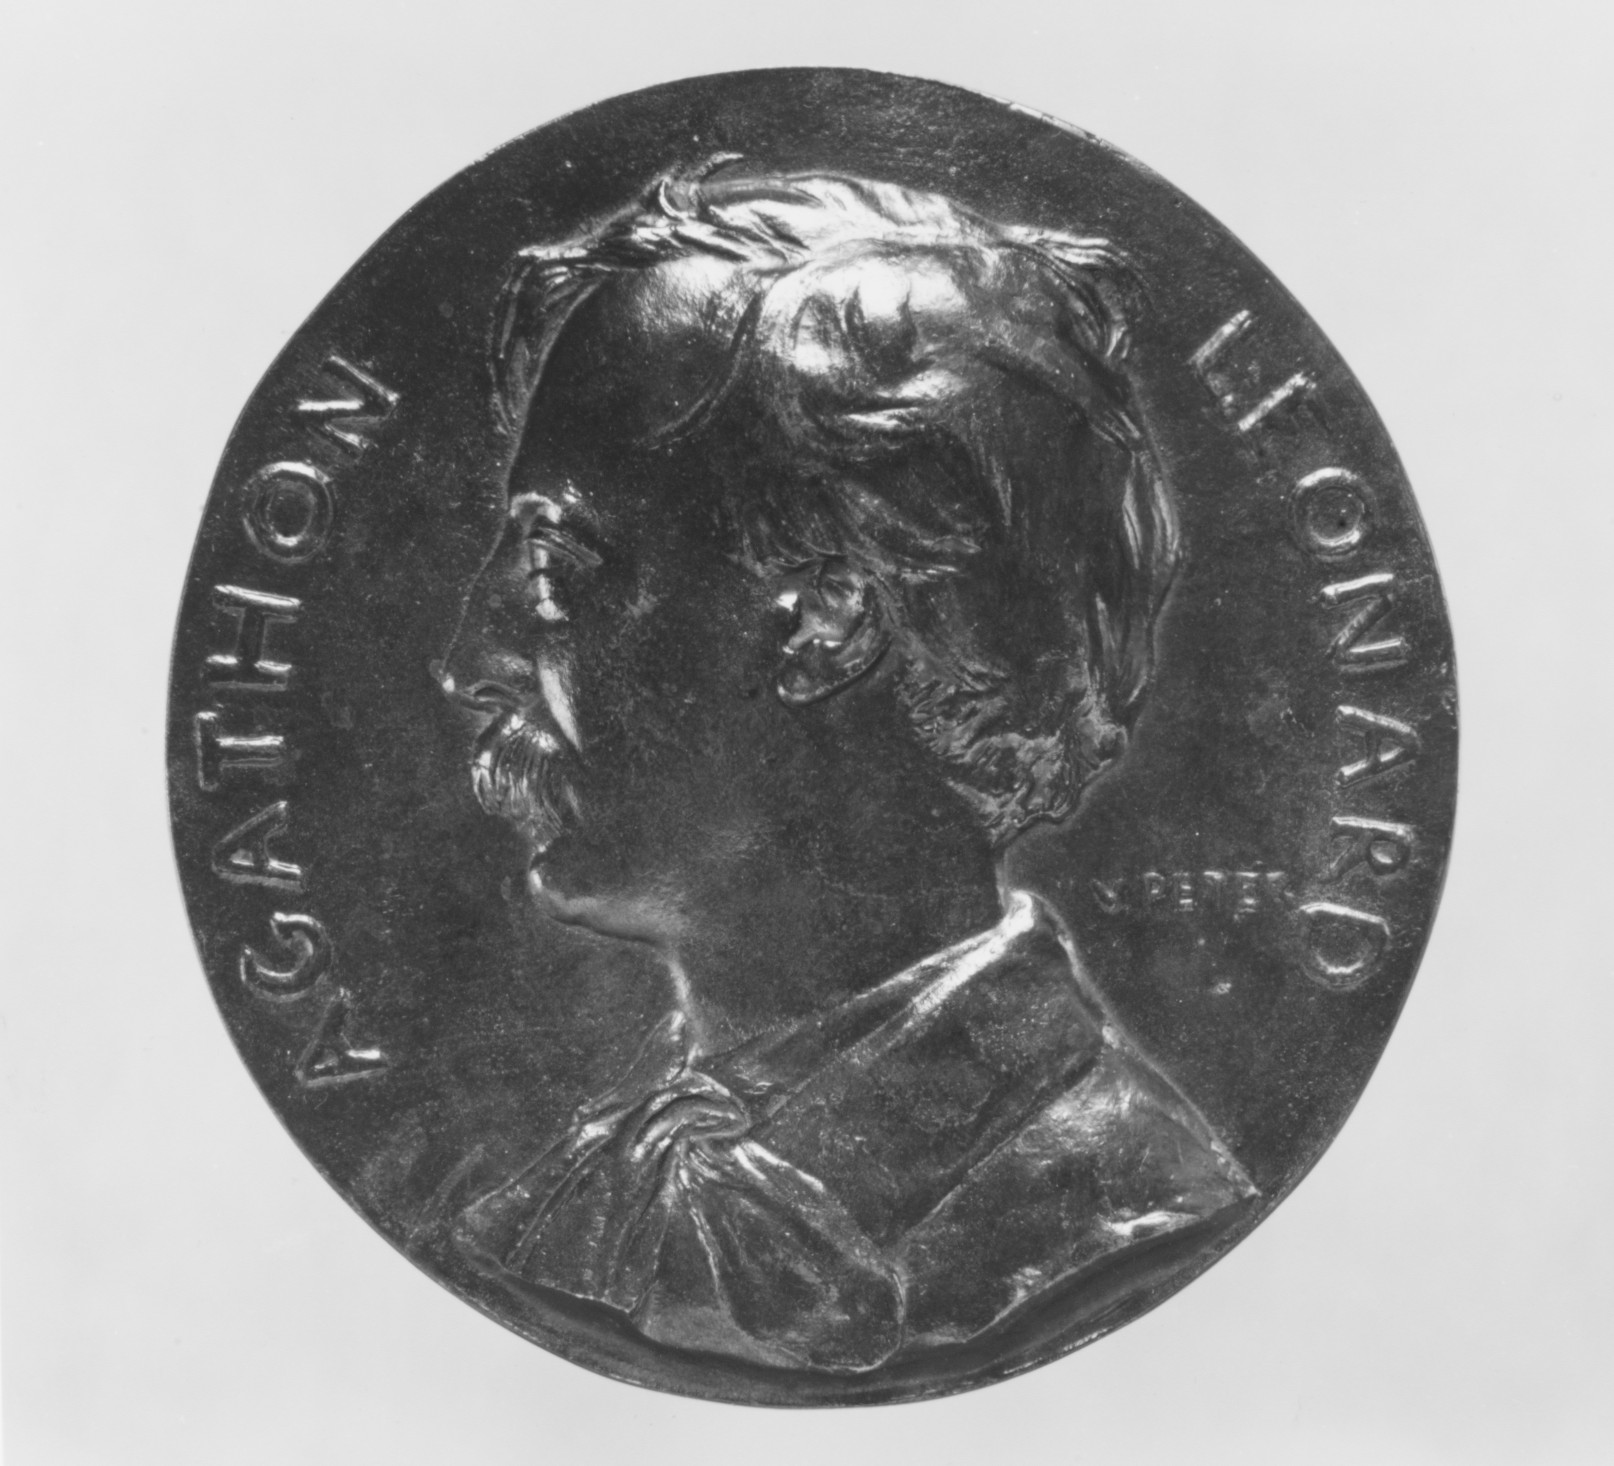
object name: medallion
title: Agathon Léonard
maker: victor peter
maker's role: artist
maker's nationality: french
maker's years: 1840-1918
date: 1900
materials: bronze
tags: men,profiles